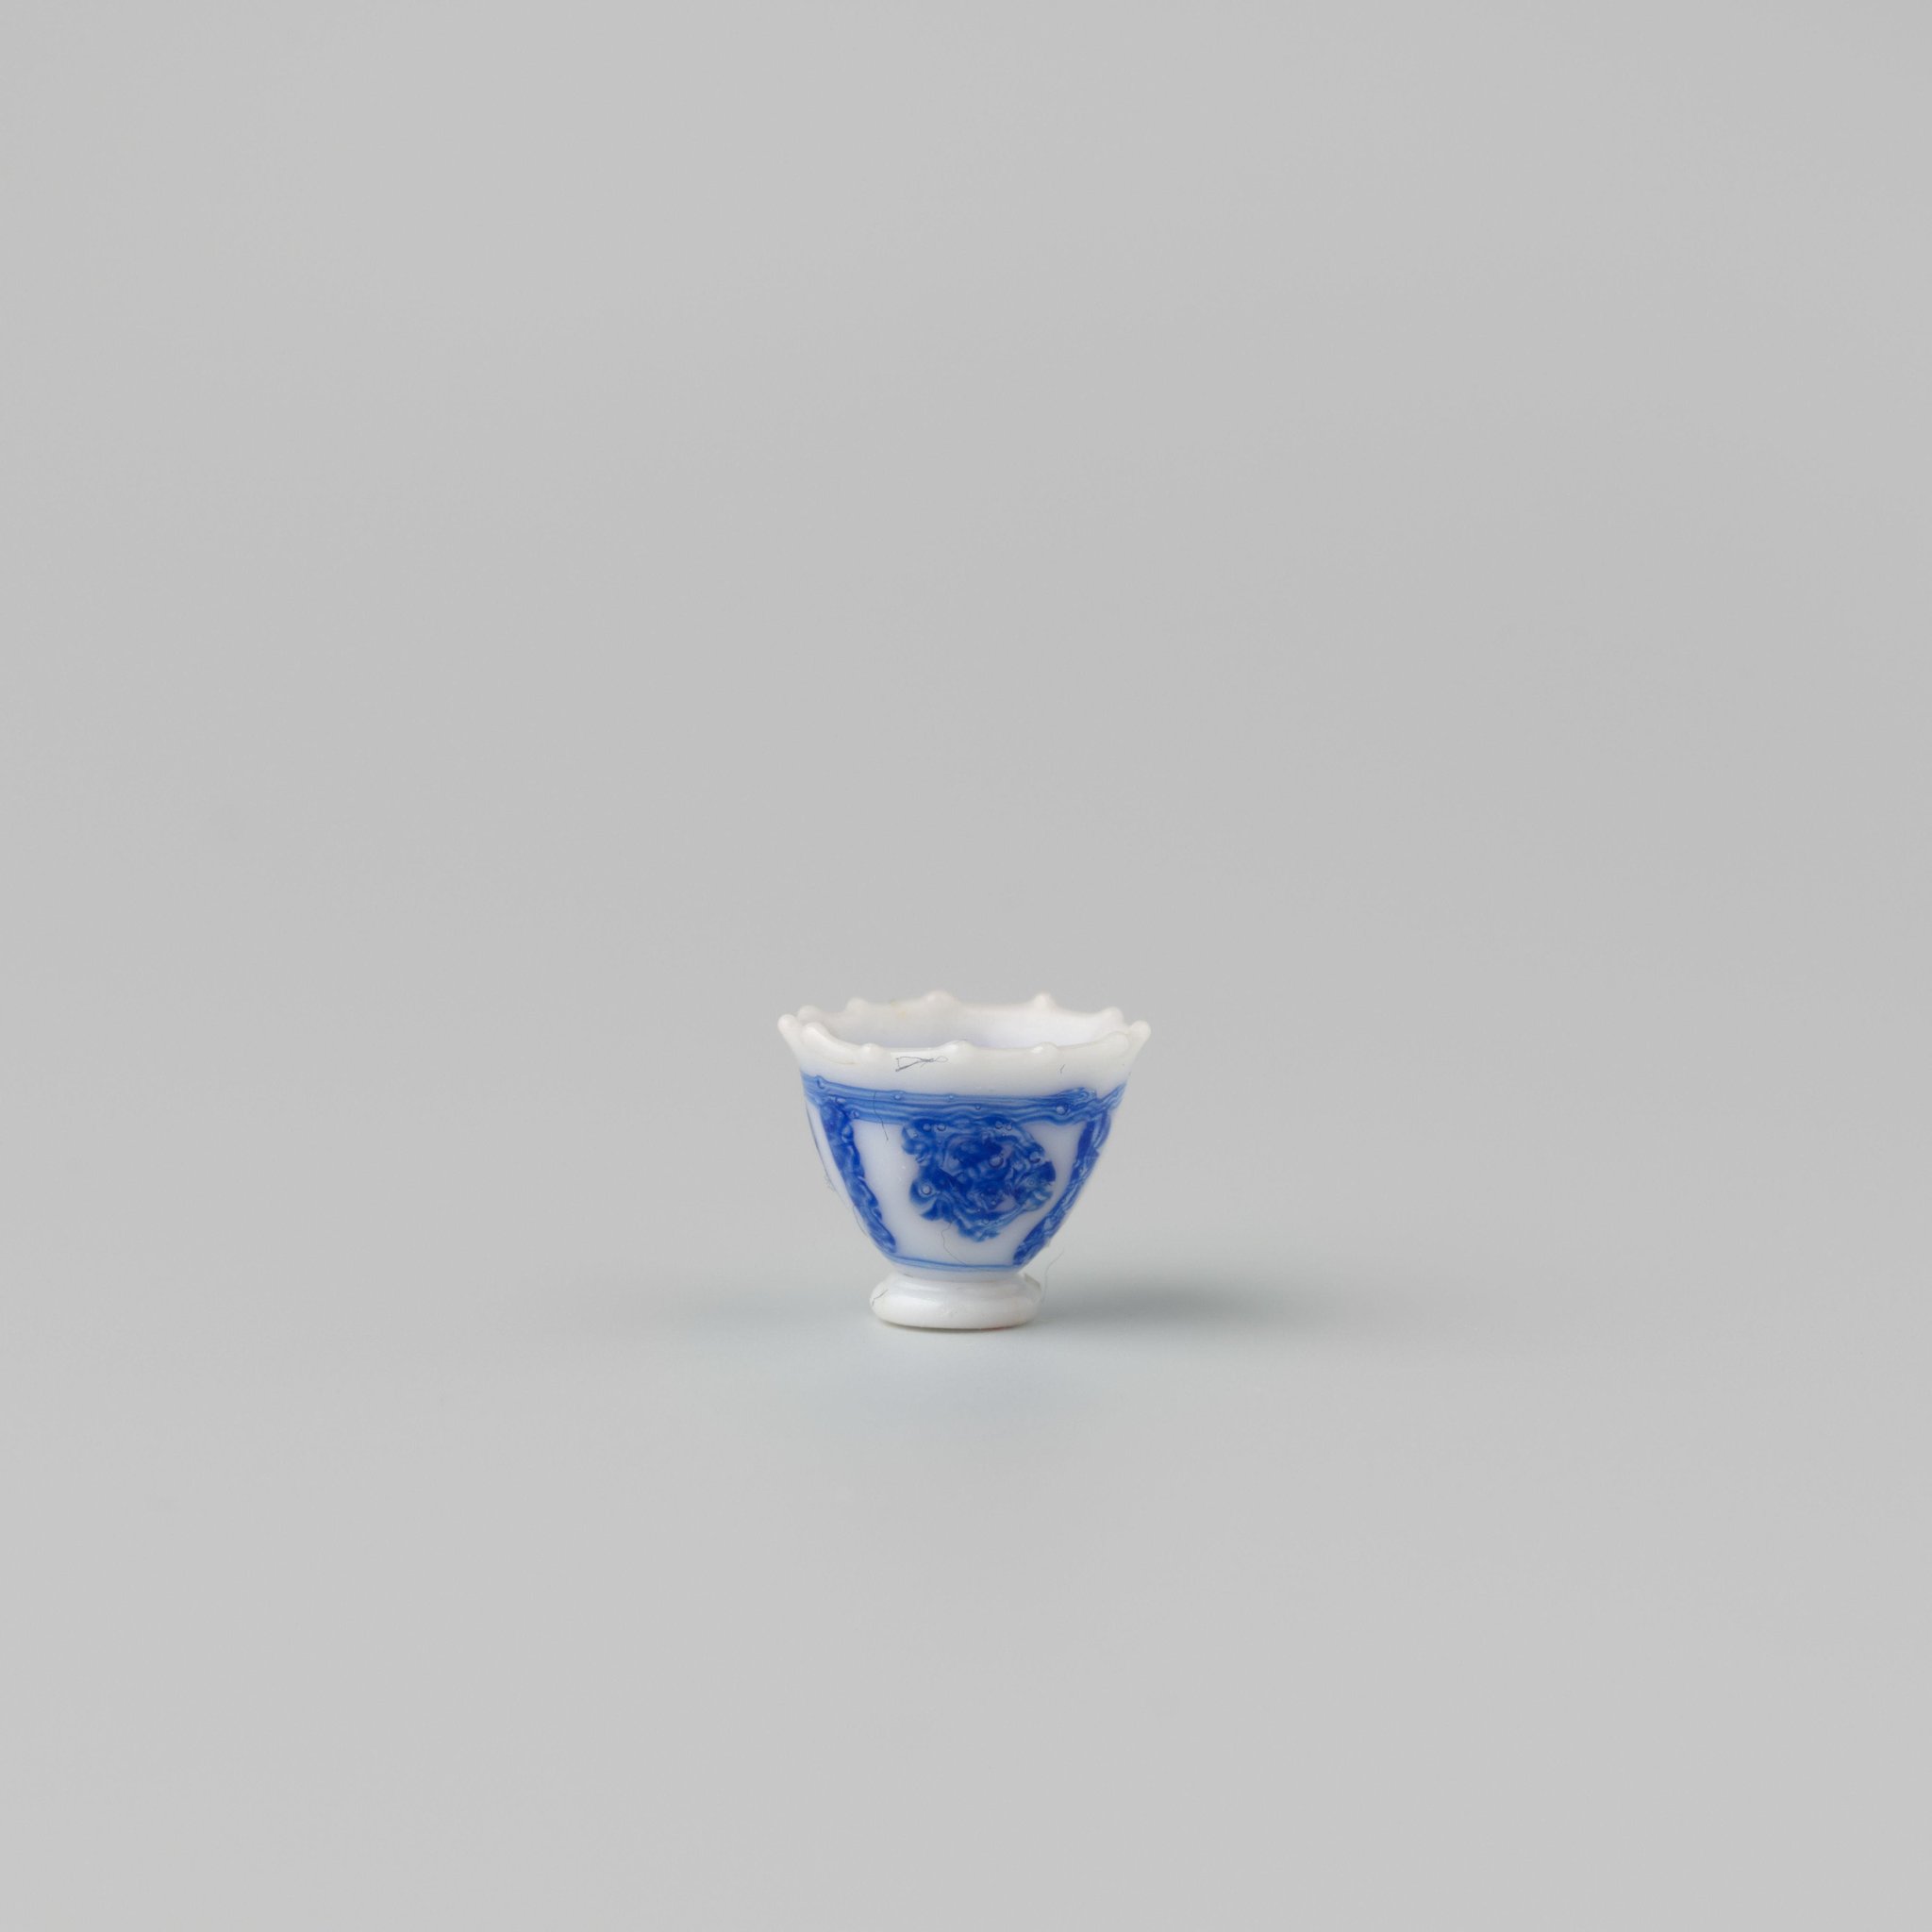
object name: miniature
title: Theekopje van melkglas met blauwe emailverf beschildering, imitatie Chinees porselein met 'bloem' decoratie in vakken; model op los aangebrachte standring en met puntrand.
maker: Anonymous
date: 1675-1710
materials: glass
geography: amsterdam